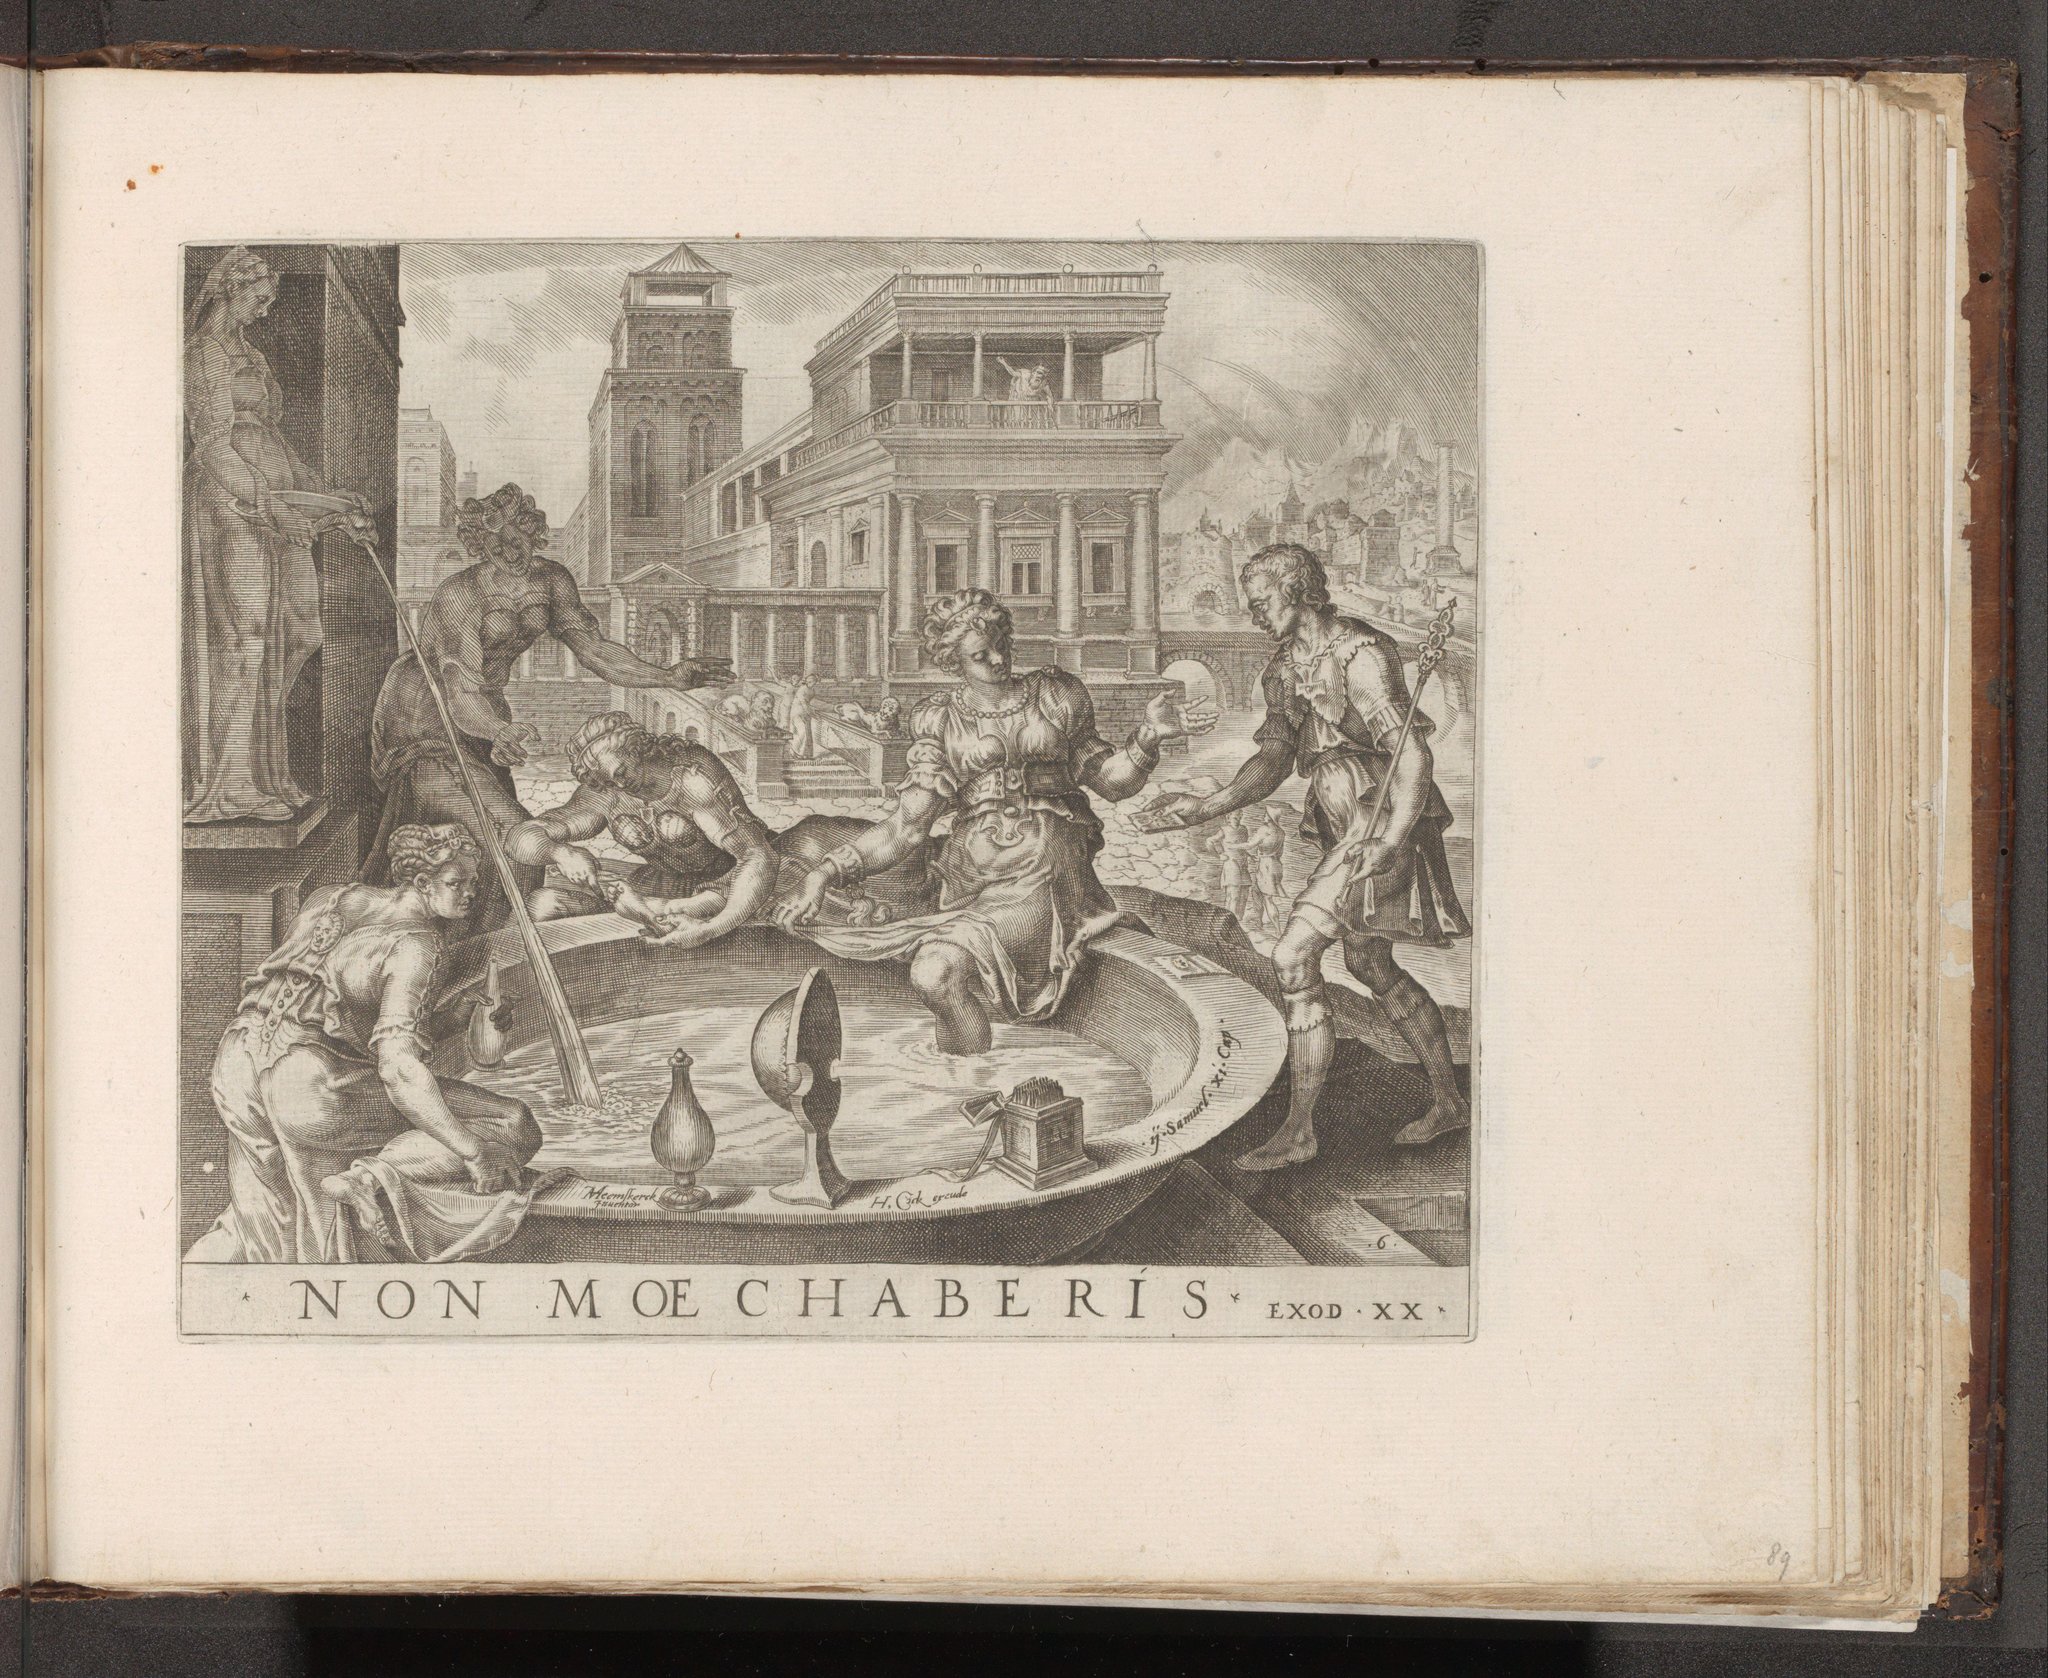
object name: album leaf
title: De tien geboden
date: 1564-1568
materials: paper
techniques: engraving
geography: amsterdam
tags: pedicure, taking a bath, mirror, garden fountain, bathsheba receives a letter from david, implements ~ making toilet, 'you shall not commit adultery' ~ separate representation of the seventh of the ten commandments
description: Batseba zit te baden in een waterbassin met fontein. Een bediende reikt haar een brief aan van koning David. David staat op het balkon van het paleis op de achtergrond. Prent maakt deel uit van een serie over de tien geboden en geeft een overtreding van het zesde gebod weer: Gij zult niet echtbreken. Onderaan in de marge een verwijzing naar de Bijbeltekst in het Latijn. Prent maakt deel uit van een album.